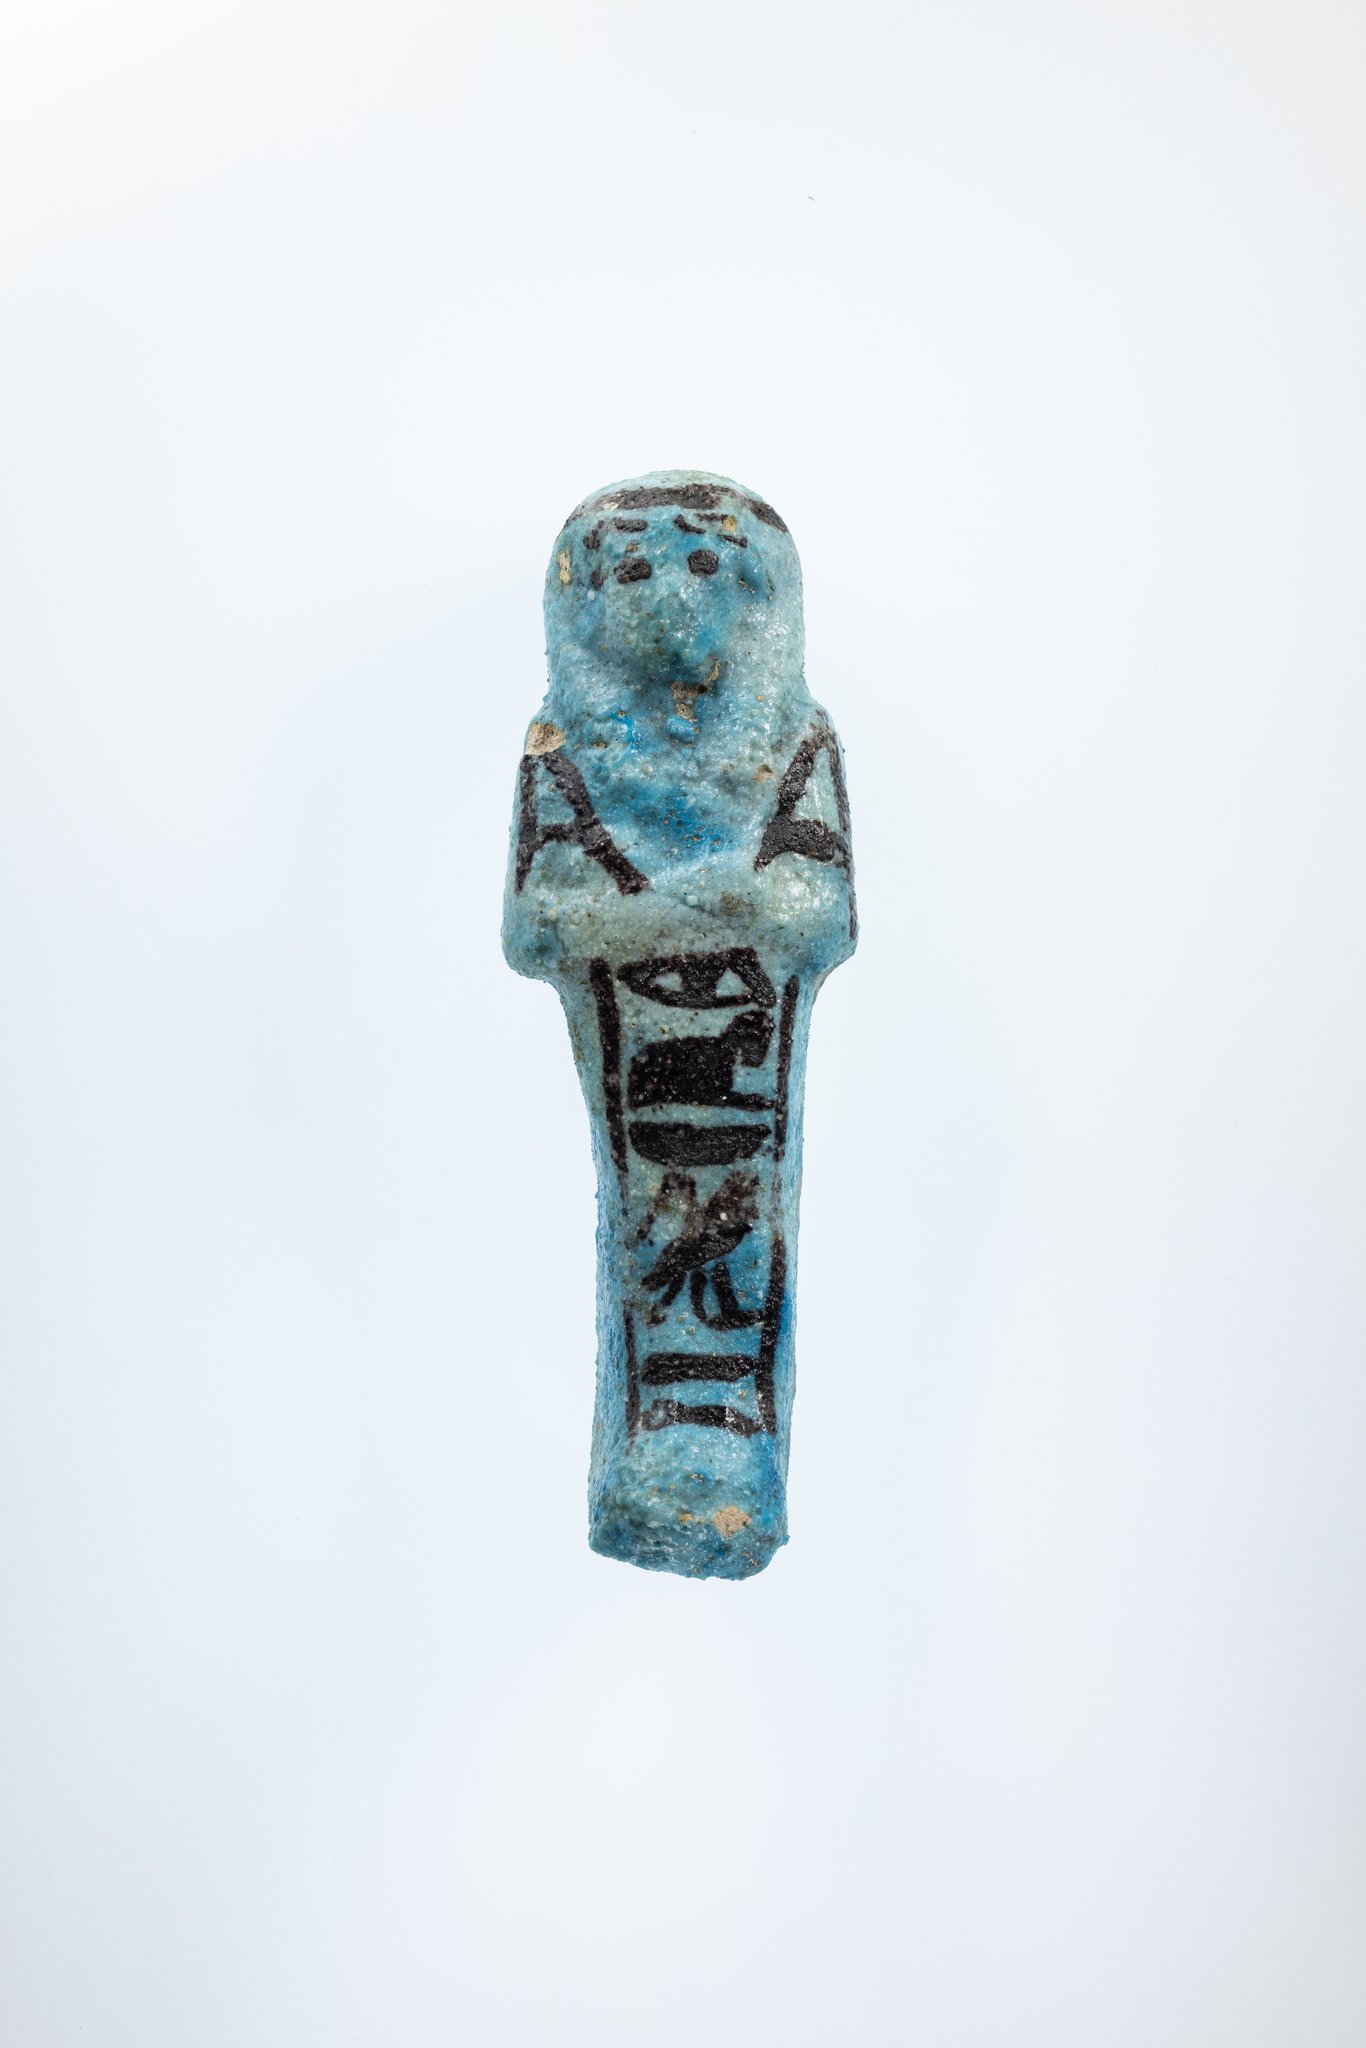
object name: shabti, nebhor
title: Shabti of Nebhor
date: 1070-712 BCE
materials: faience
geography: egypt